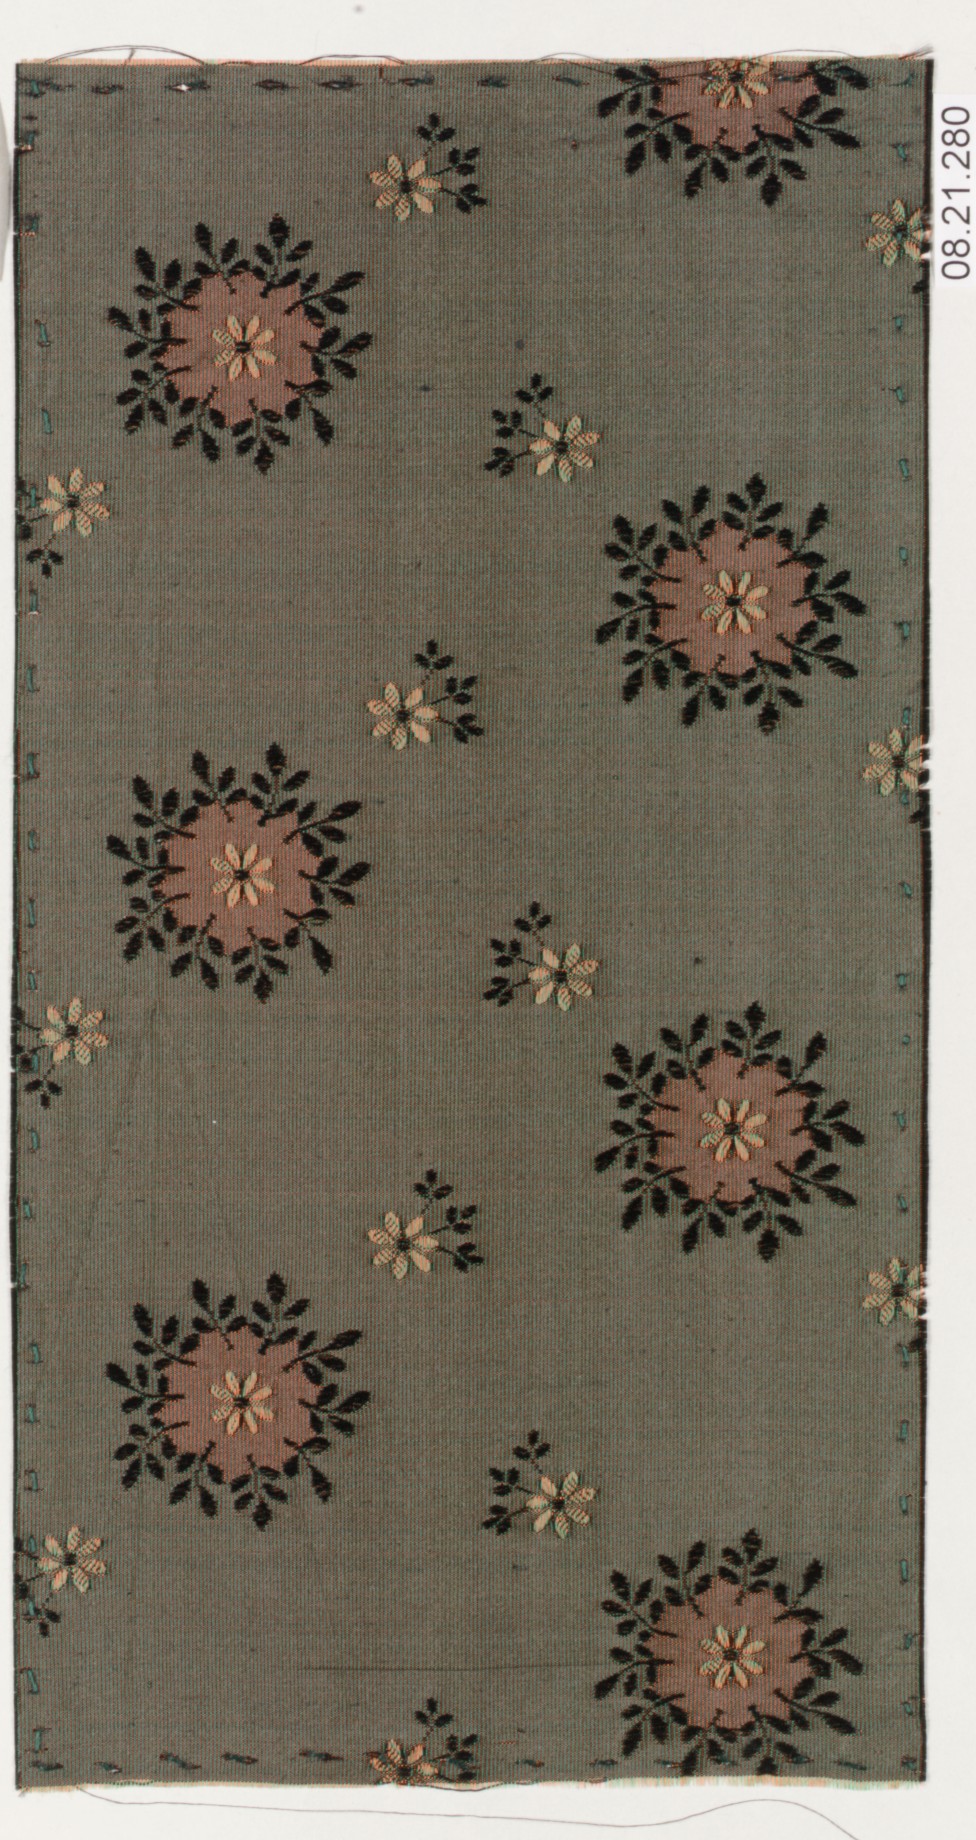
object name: textile sample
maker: Anonymous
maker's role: designer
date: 1900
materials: silk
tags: flowers